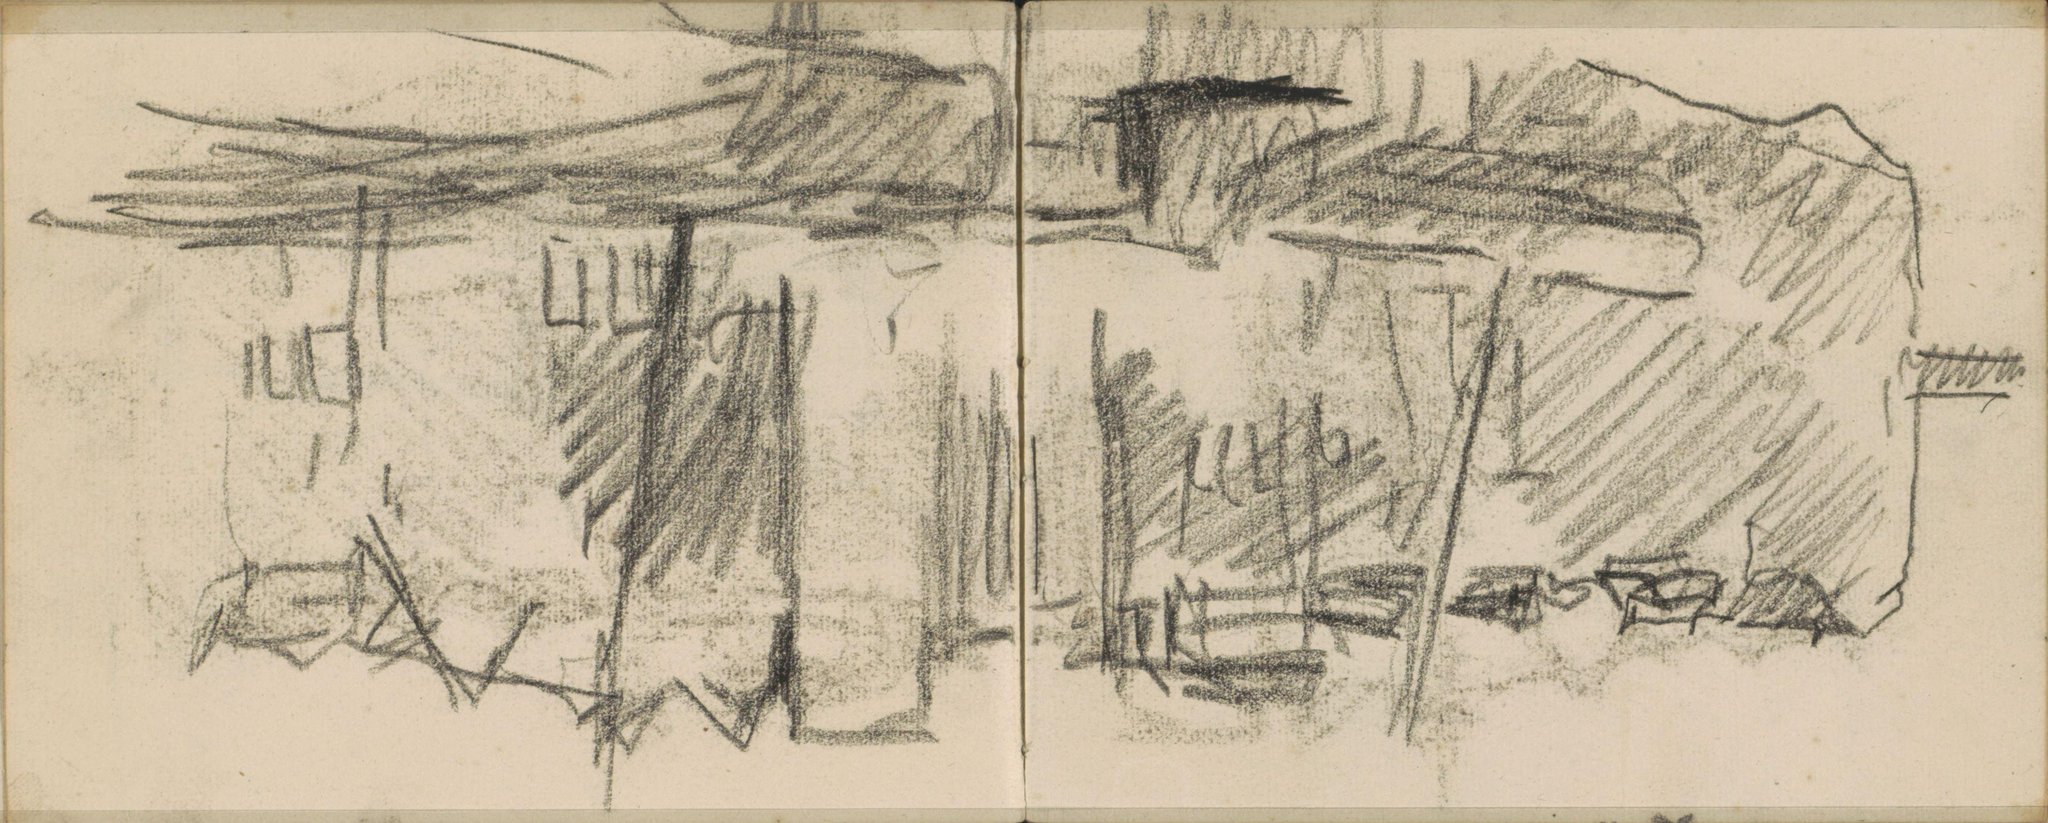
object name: sketchbook leaf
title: Gezicht in Amsterdam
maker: george hendrik breitner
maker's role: draughtsman, painter, print maker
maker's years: 1857-1923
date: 1886-1903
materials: chalk, paper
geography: amsterdam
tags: urban housing, ships (in general), canals, waters (in city), amsterdam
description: Pagina 23 en pagina 24 uit een schetsboek met 27 bladen.